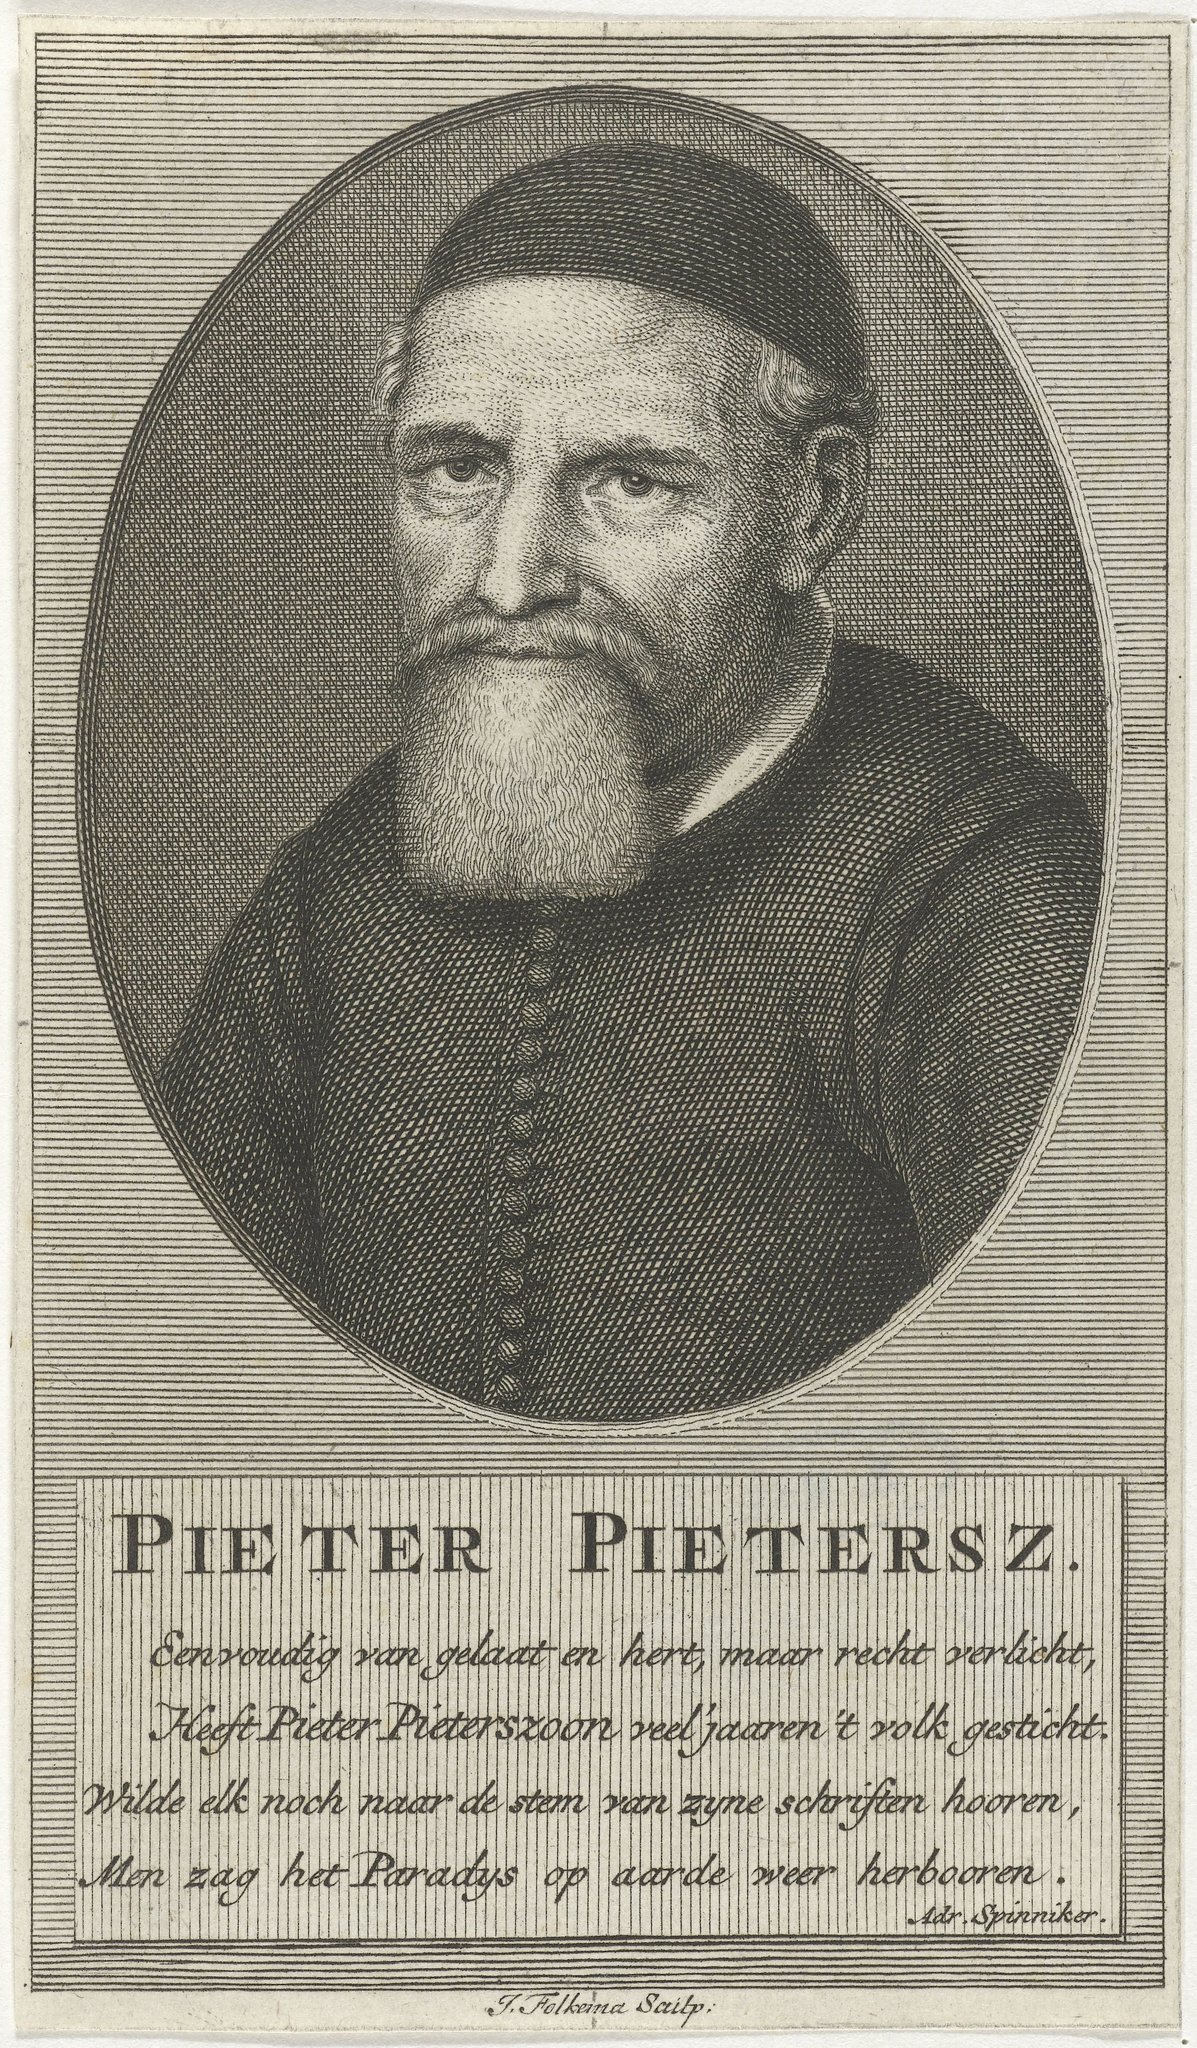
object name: print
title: Portret van Pieter Pietersz.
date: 1744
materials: paper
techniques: engraving, etching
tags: schrijver, predikant, pieter pietersz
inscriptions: collector's mark: Lugt 2228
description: Prent mogelijk uit: Schijn, Hermannus. Geschiedenis dier christenen, welke in de Vereenigde Nederlanden onder de protestanten mennoniten genaamd worden. Amsterdam: Kornelis de Wit, 1744, dl. 2. Prent met omlijsting gebruikt in: Verzaameling van de afbeeldingen van veele voornaame mannen en leeraaren. Amsterdam: Kornelis de Wit, 1743.